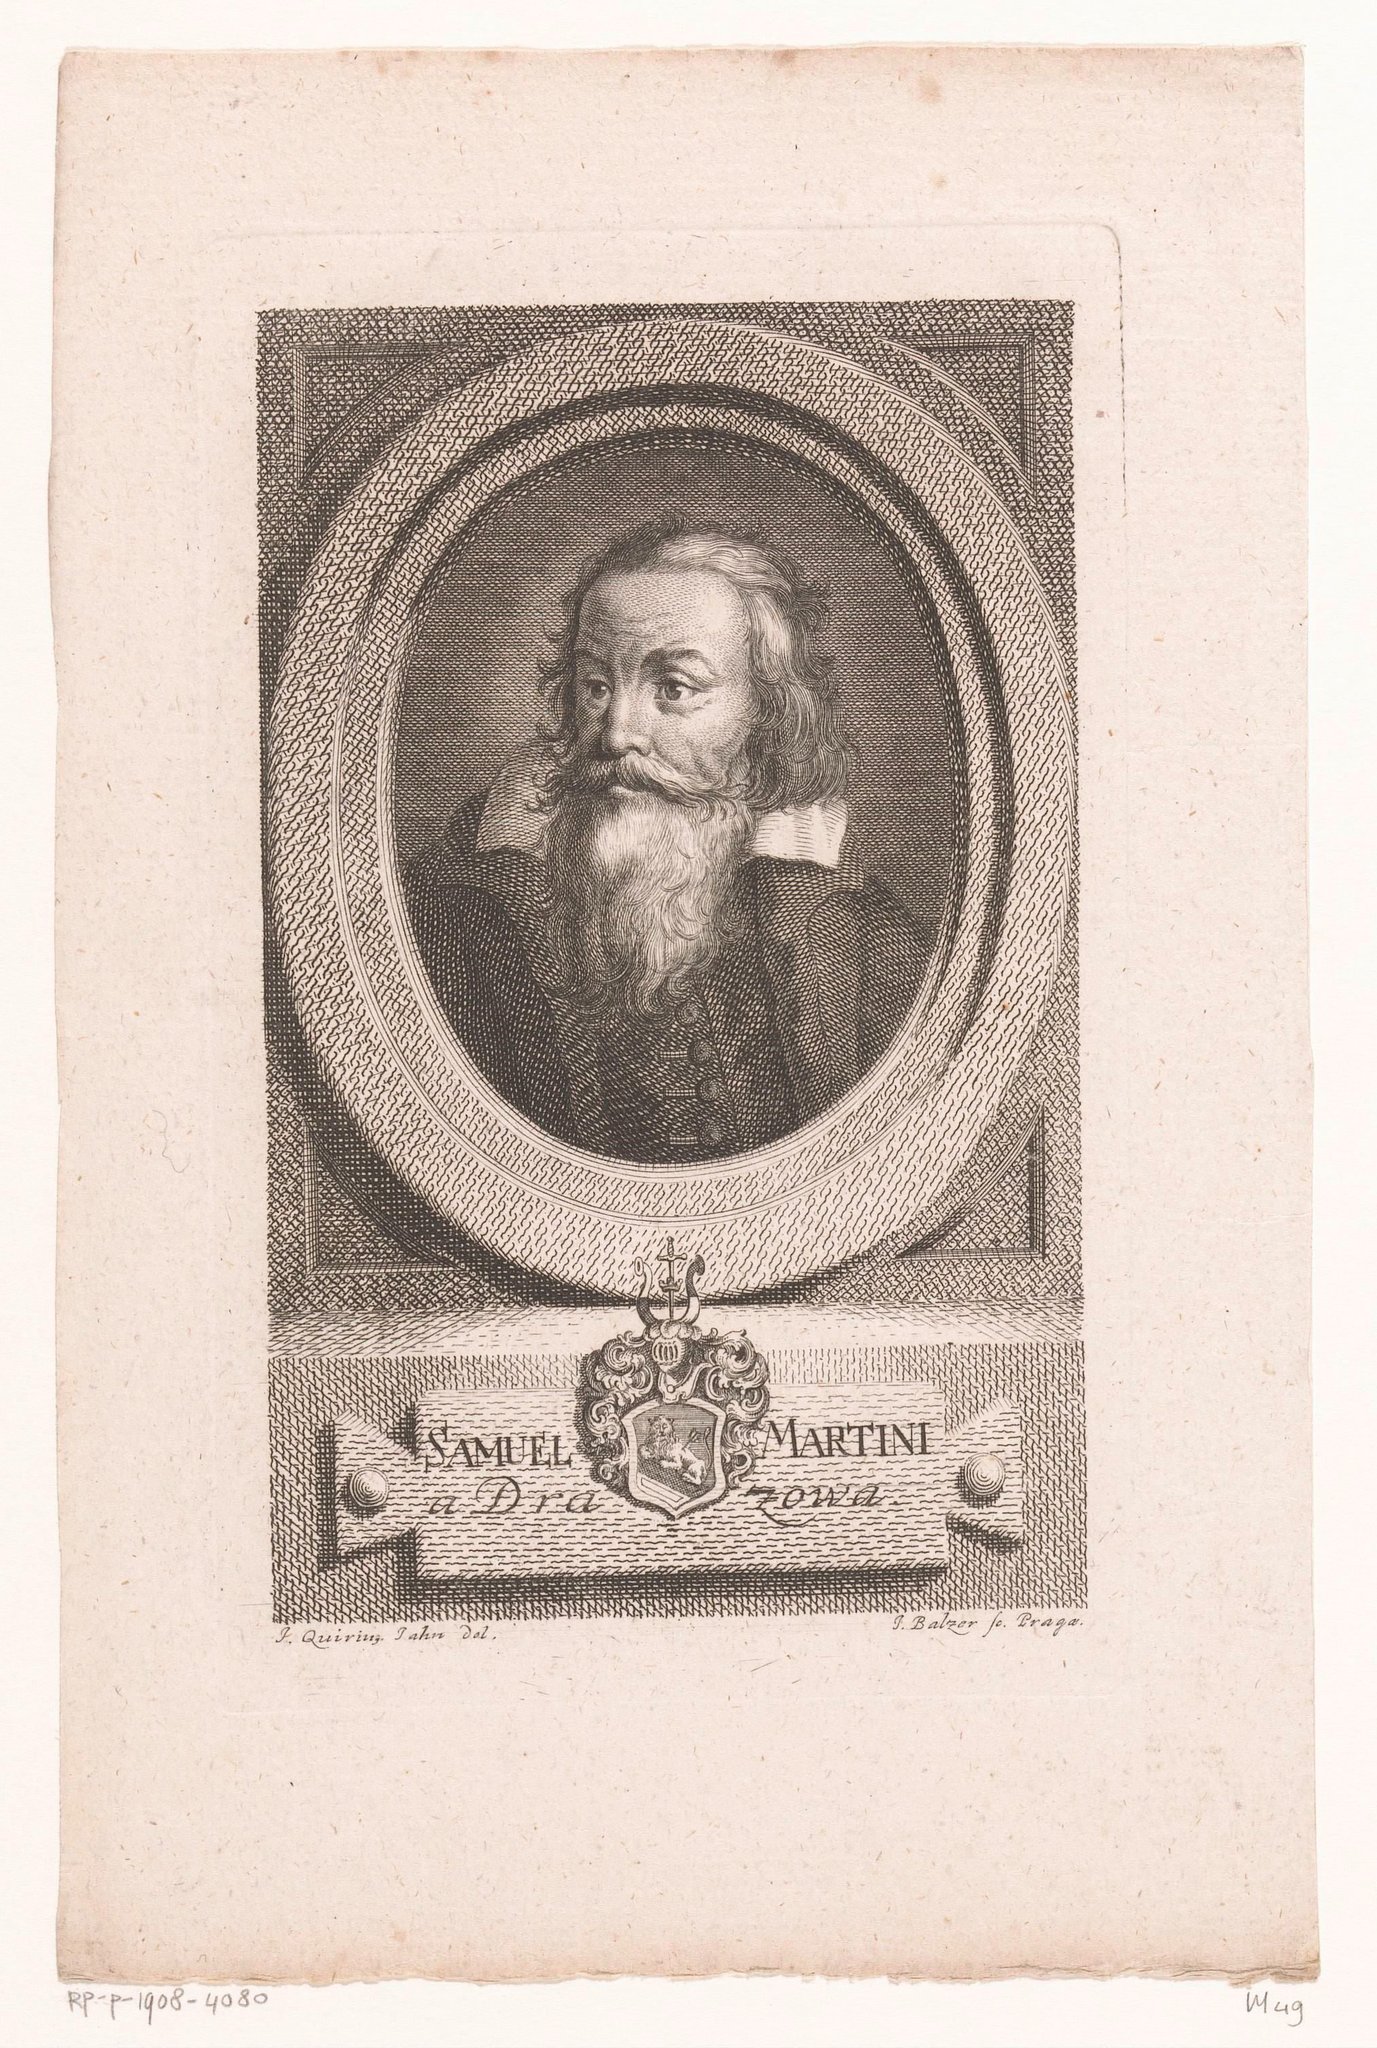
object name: print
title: Samuel Martini a Drazowa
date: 1749-1799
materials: paper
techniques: engraving, etching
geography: prague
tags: historical persons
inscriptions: collector's mark: Lugt 2228